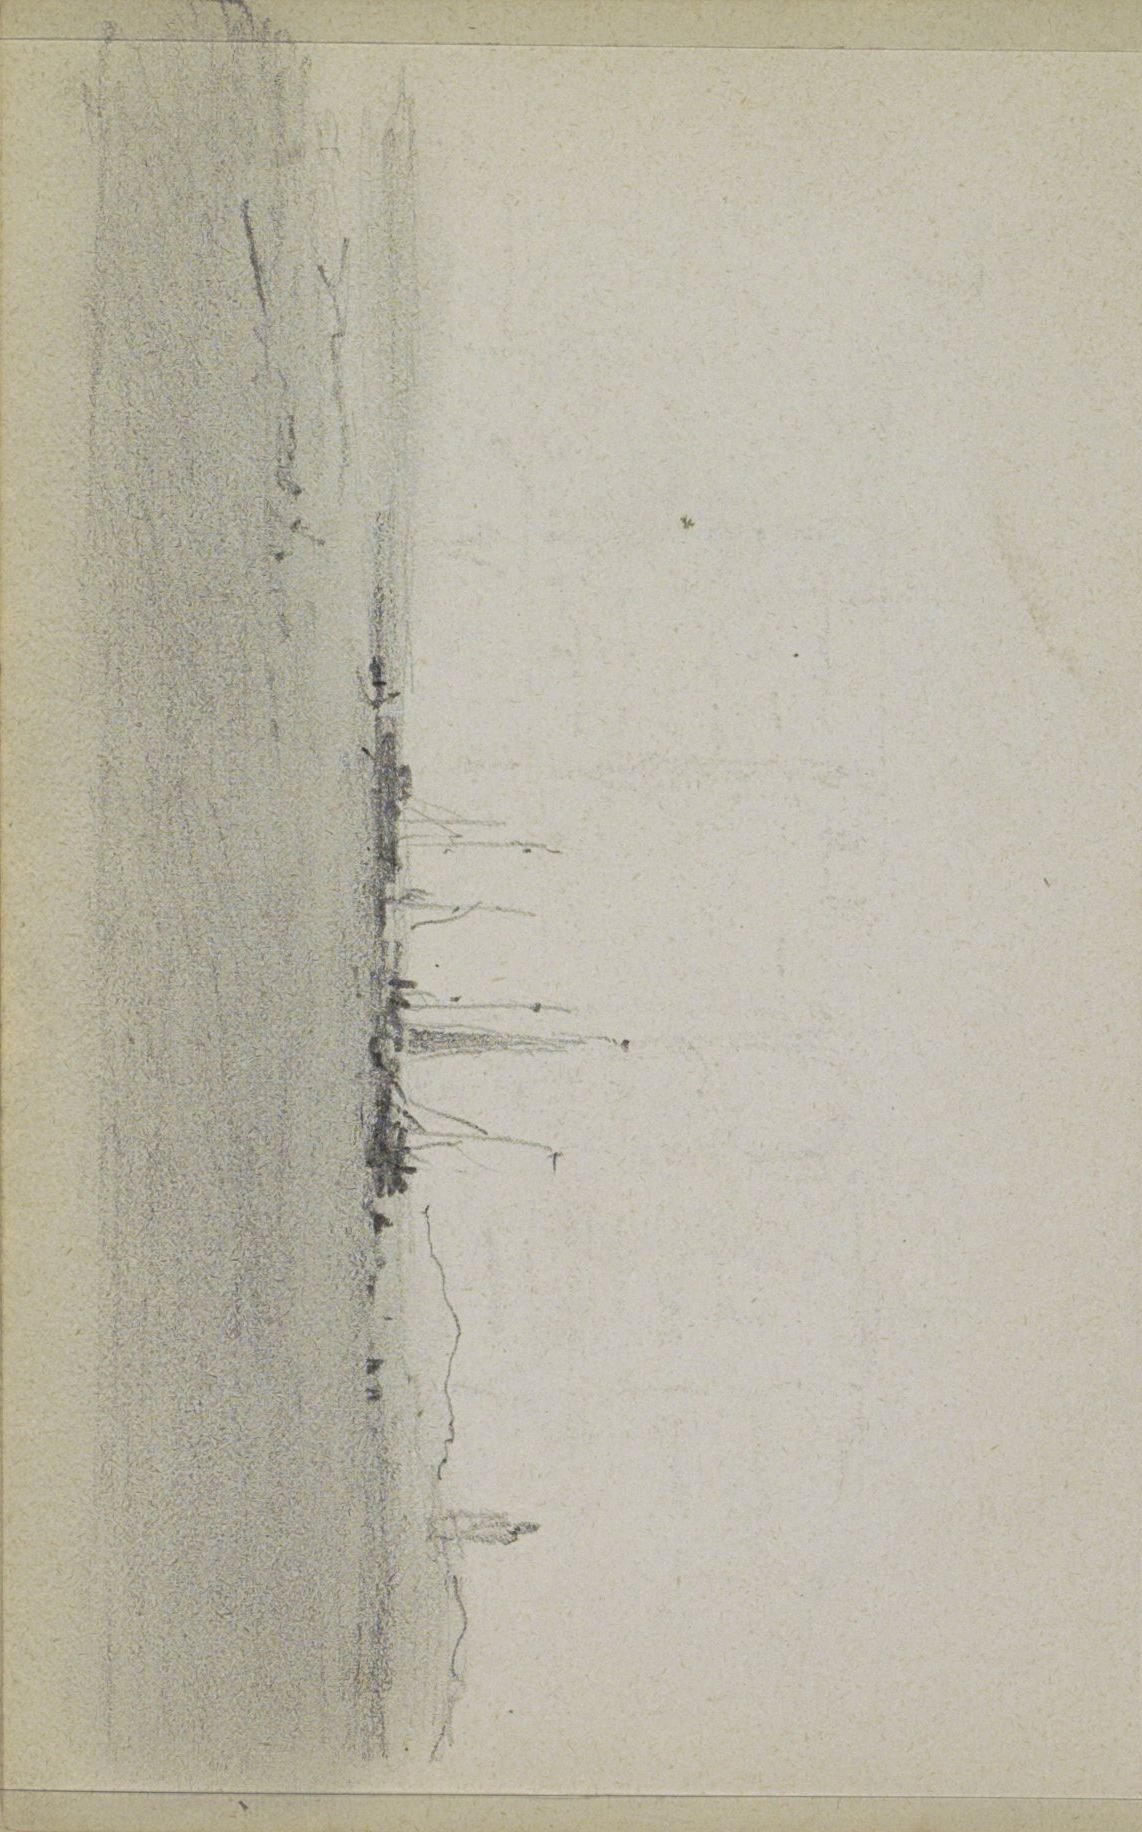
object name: sketchbook leaf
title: Landschap met water en zeilschepen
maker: adrianus eversen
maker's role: draughtsman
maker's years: 1818-1897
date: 1828-1897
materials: paper, pencil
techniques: stumping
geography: netherlands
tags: sailing-ship, sailing-boat, landscapes with waters, waterscapes, seascapes (in the temperate zone), tower (of house or building)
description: Landschap met water, mogelijk de zee of een rivier. In het water zeilschepen. Rechts in de verte een toren. Blad 12 verso uit een schetsboek met 58 bladen.